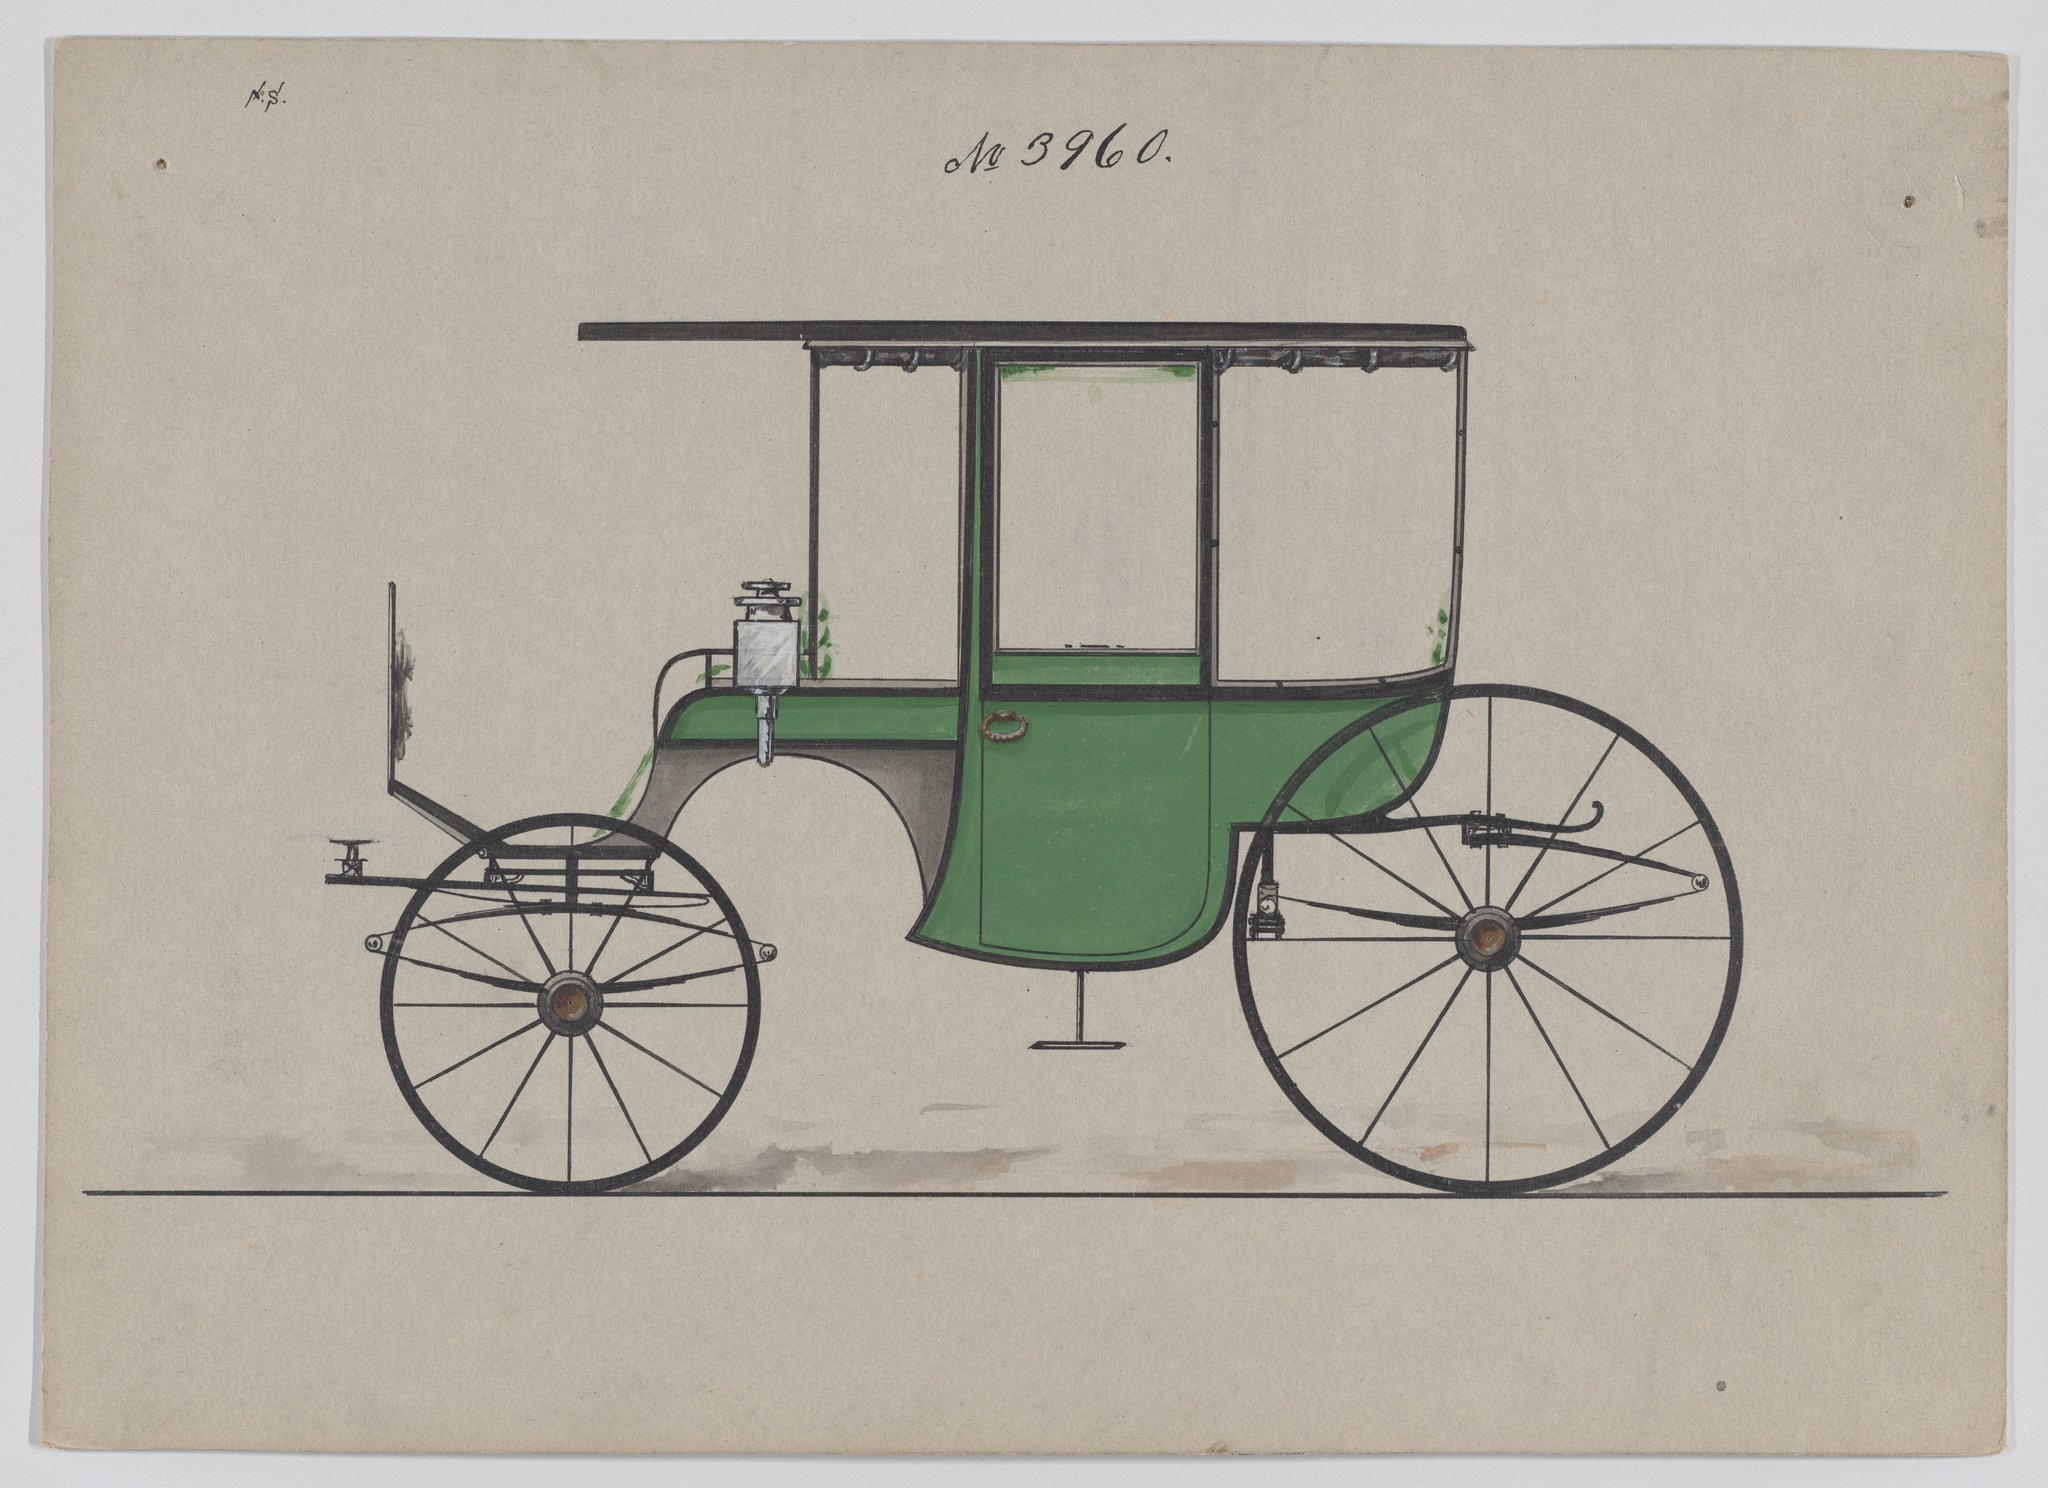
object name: drawing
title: Design for 6 seat Rockaway, no. 3960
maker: brewster & co.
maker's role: manufacturer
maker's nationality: american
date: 1886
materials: gouache, ink, watercolor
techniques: pen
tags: carriages